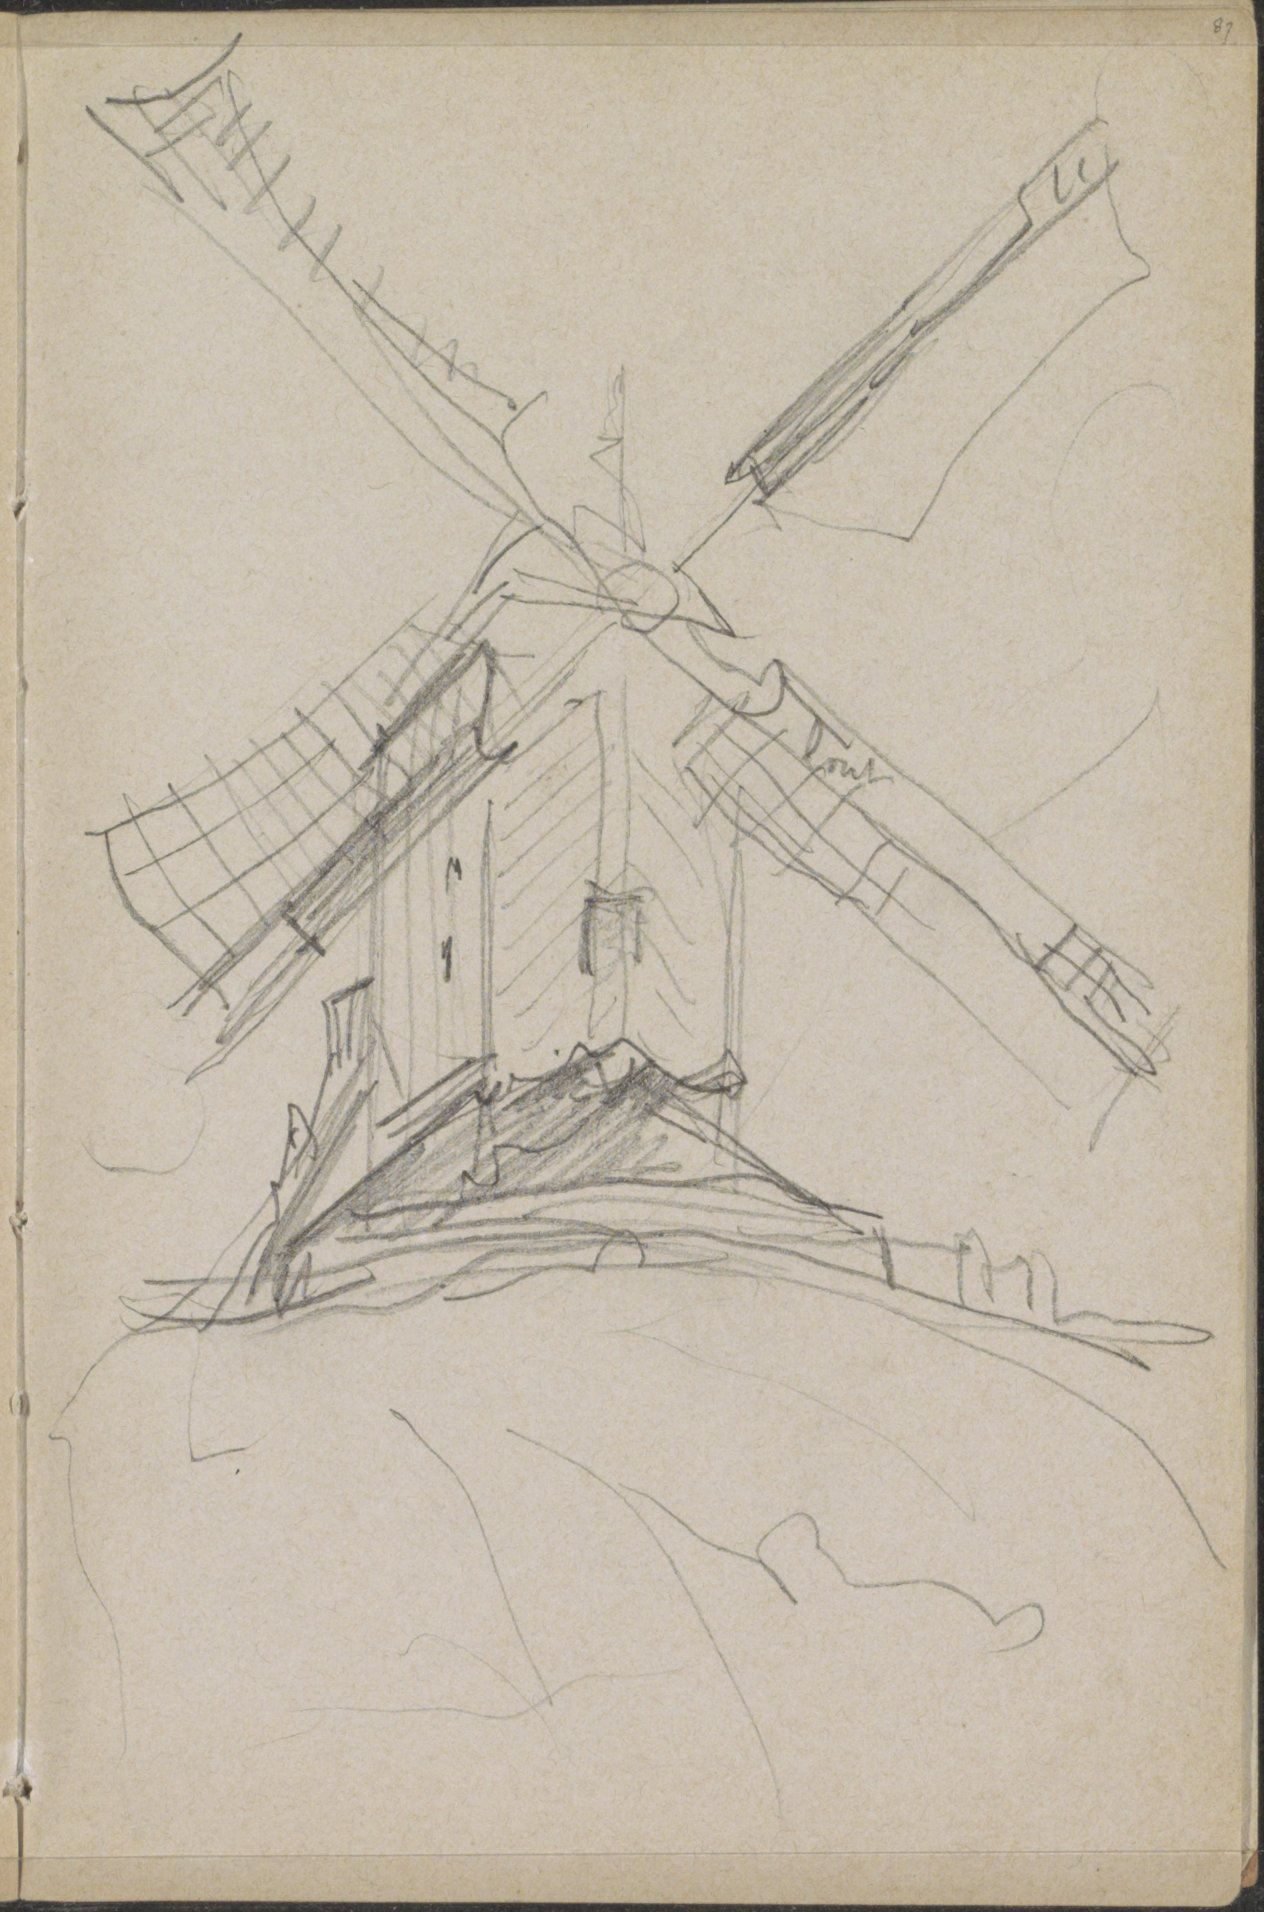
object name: sketchbook leaf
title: Windmolen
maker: marius bauer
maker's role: draughtsman, print maker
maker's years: 1867-1932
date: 1896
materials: chalk, paper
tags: windmill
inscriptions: annotation: ‘hout’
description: Pagina 87 uit een schetsboek met 45 bladen.